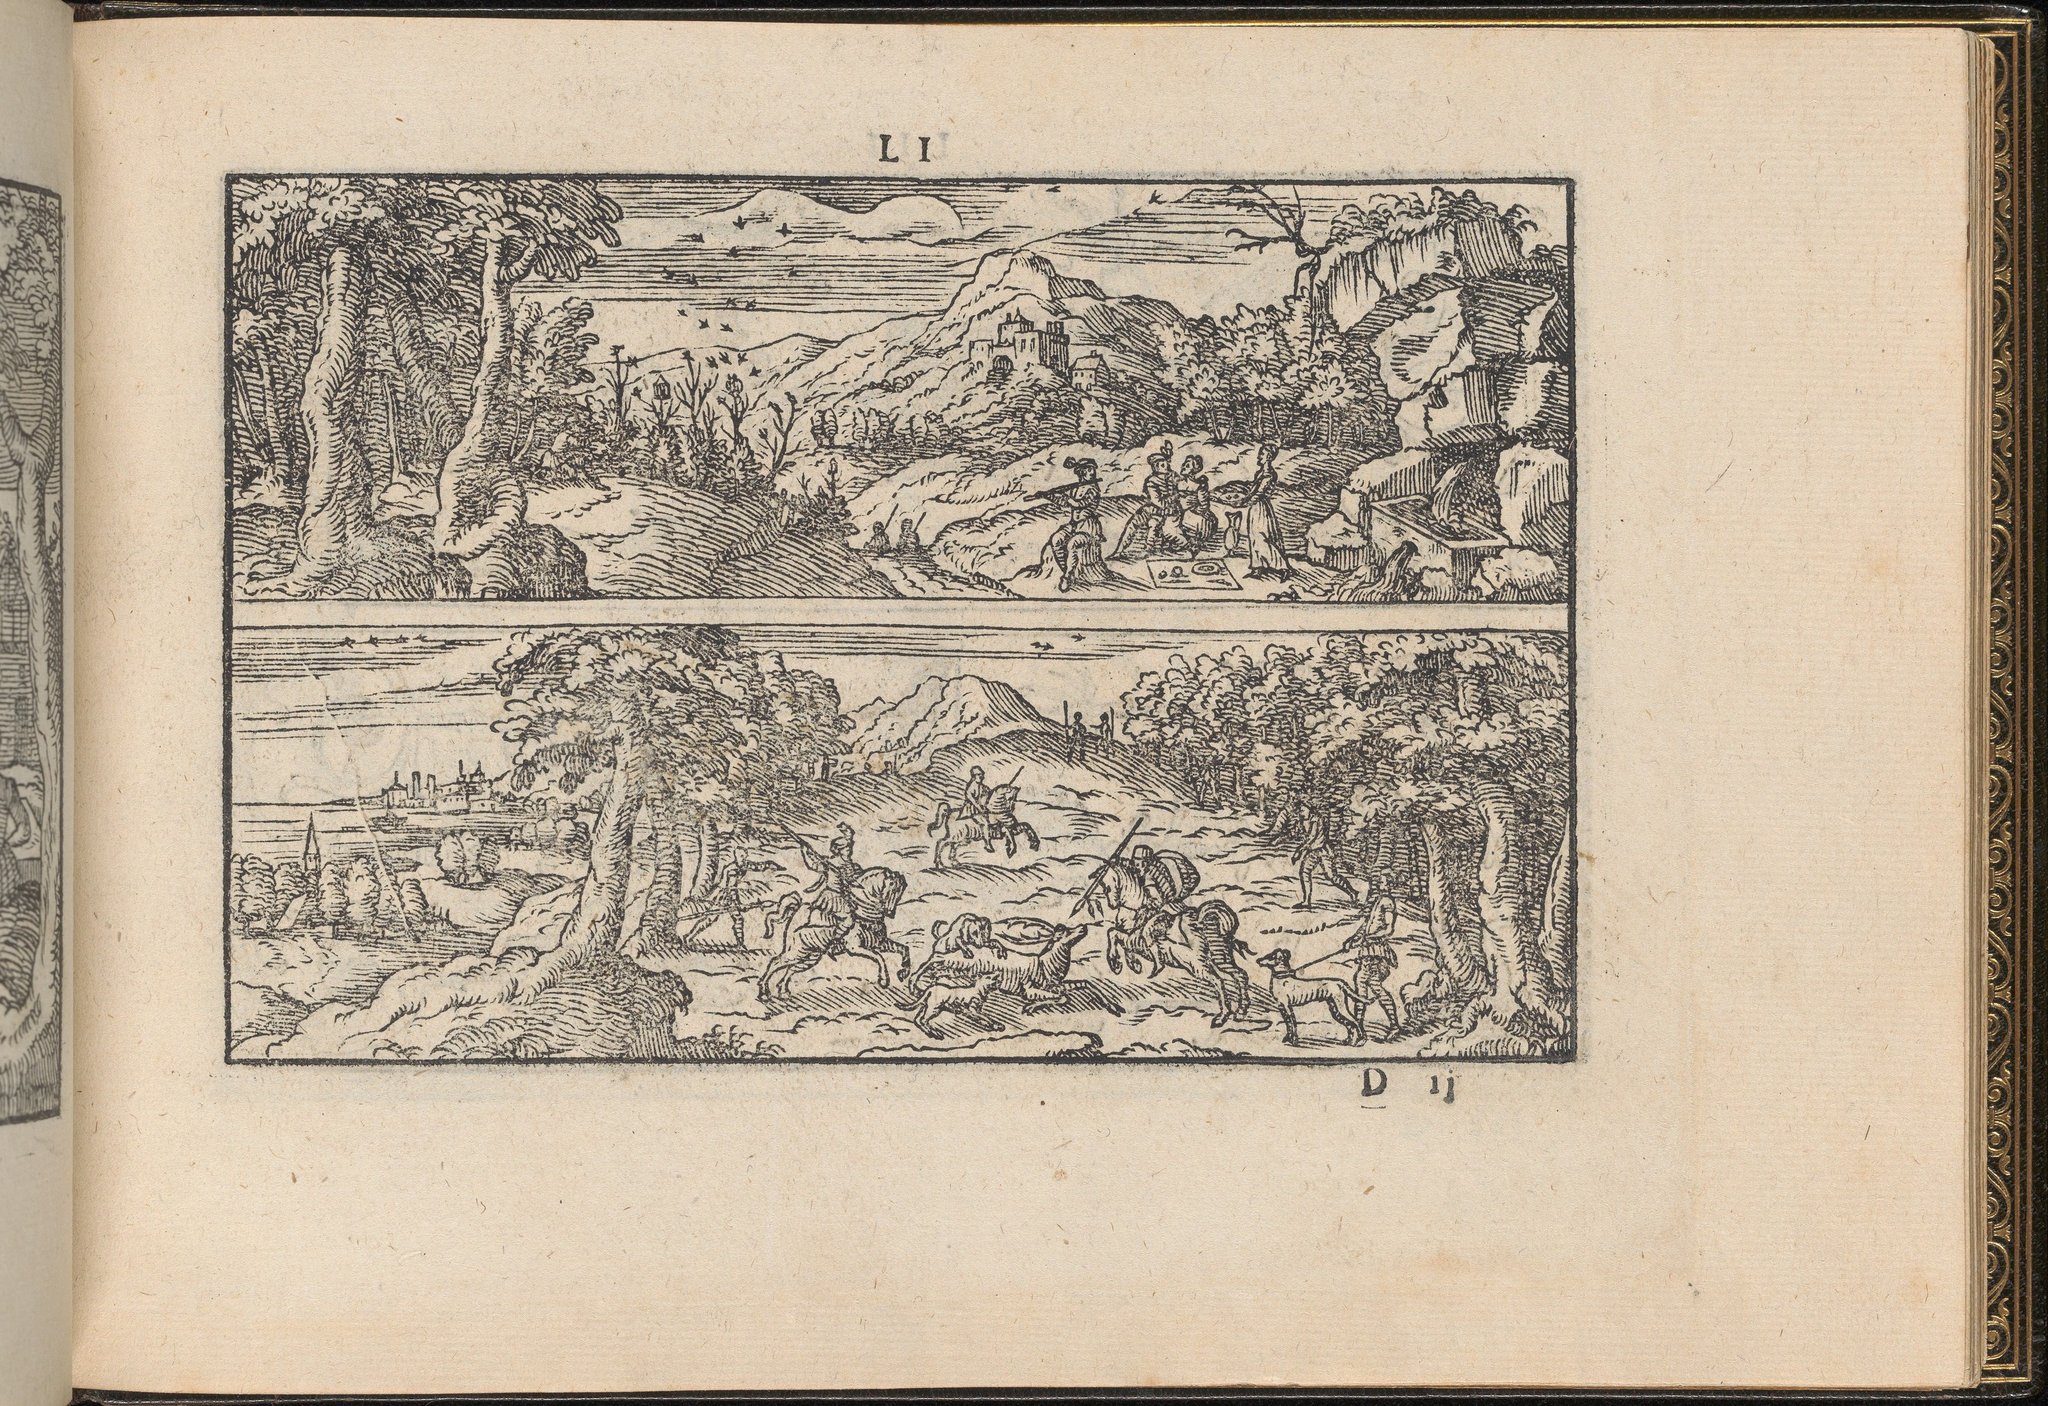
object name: book print ornament architecture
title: La Vera Perfettione del Disegno di varie sorti di recami, page 26 (recto)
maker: giovanni ostaus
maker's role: publisher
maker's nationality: italian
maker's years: 1507-1607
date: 1567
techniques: woodcut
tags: human figures,battles,horses,landscapes